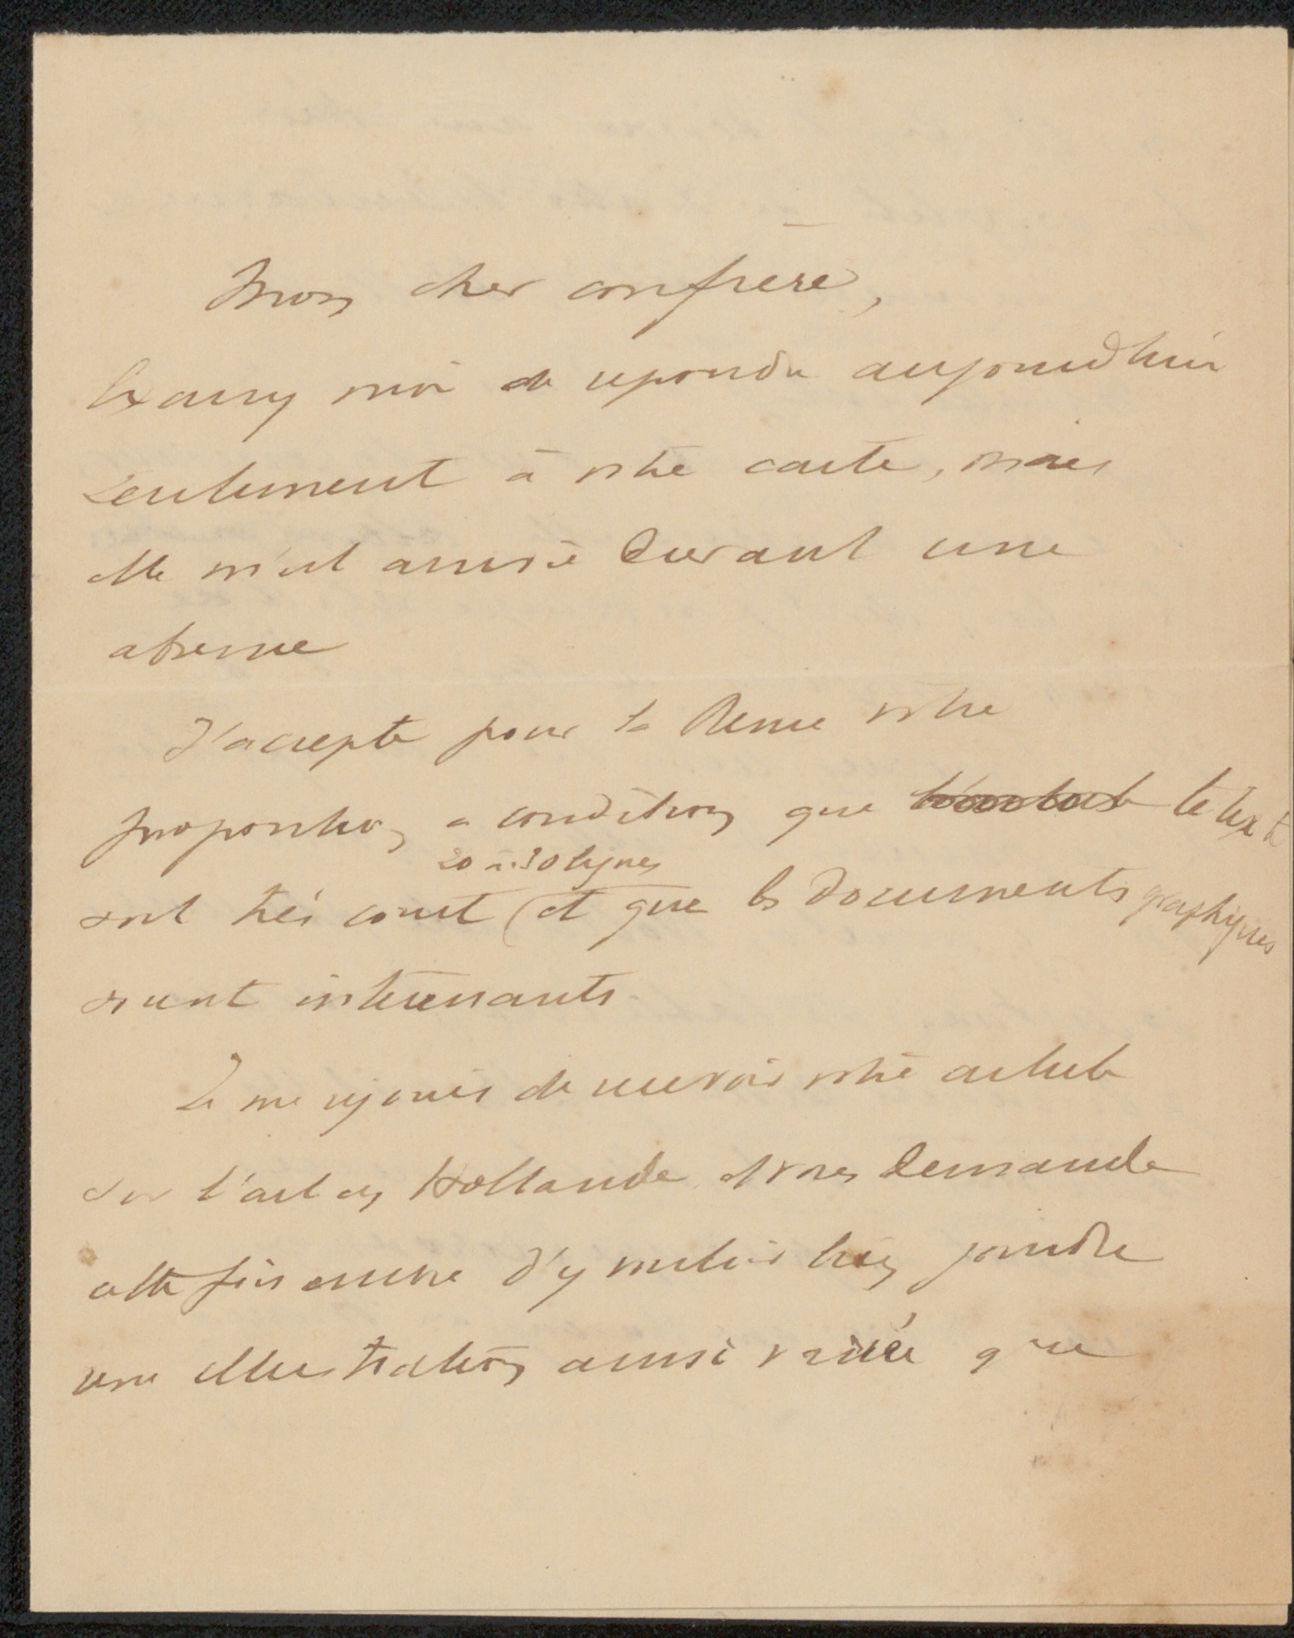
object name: letter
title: Brief aan Philip Zilcken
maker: roger marx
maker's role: kunstcriticus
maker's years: 1859-1913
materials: ink, paper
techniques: pen, writing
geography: paris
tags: amsterdam, baruch de spinoza, the hague, painter, philip zilcken, photography, cinematography, printed matter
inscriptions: collector's mark: ‘RPK’